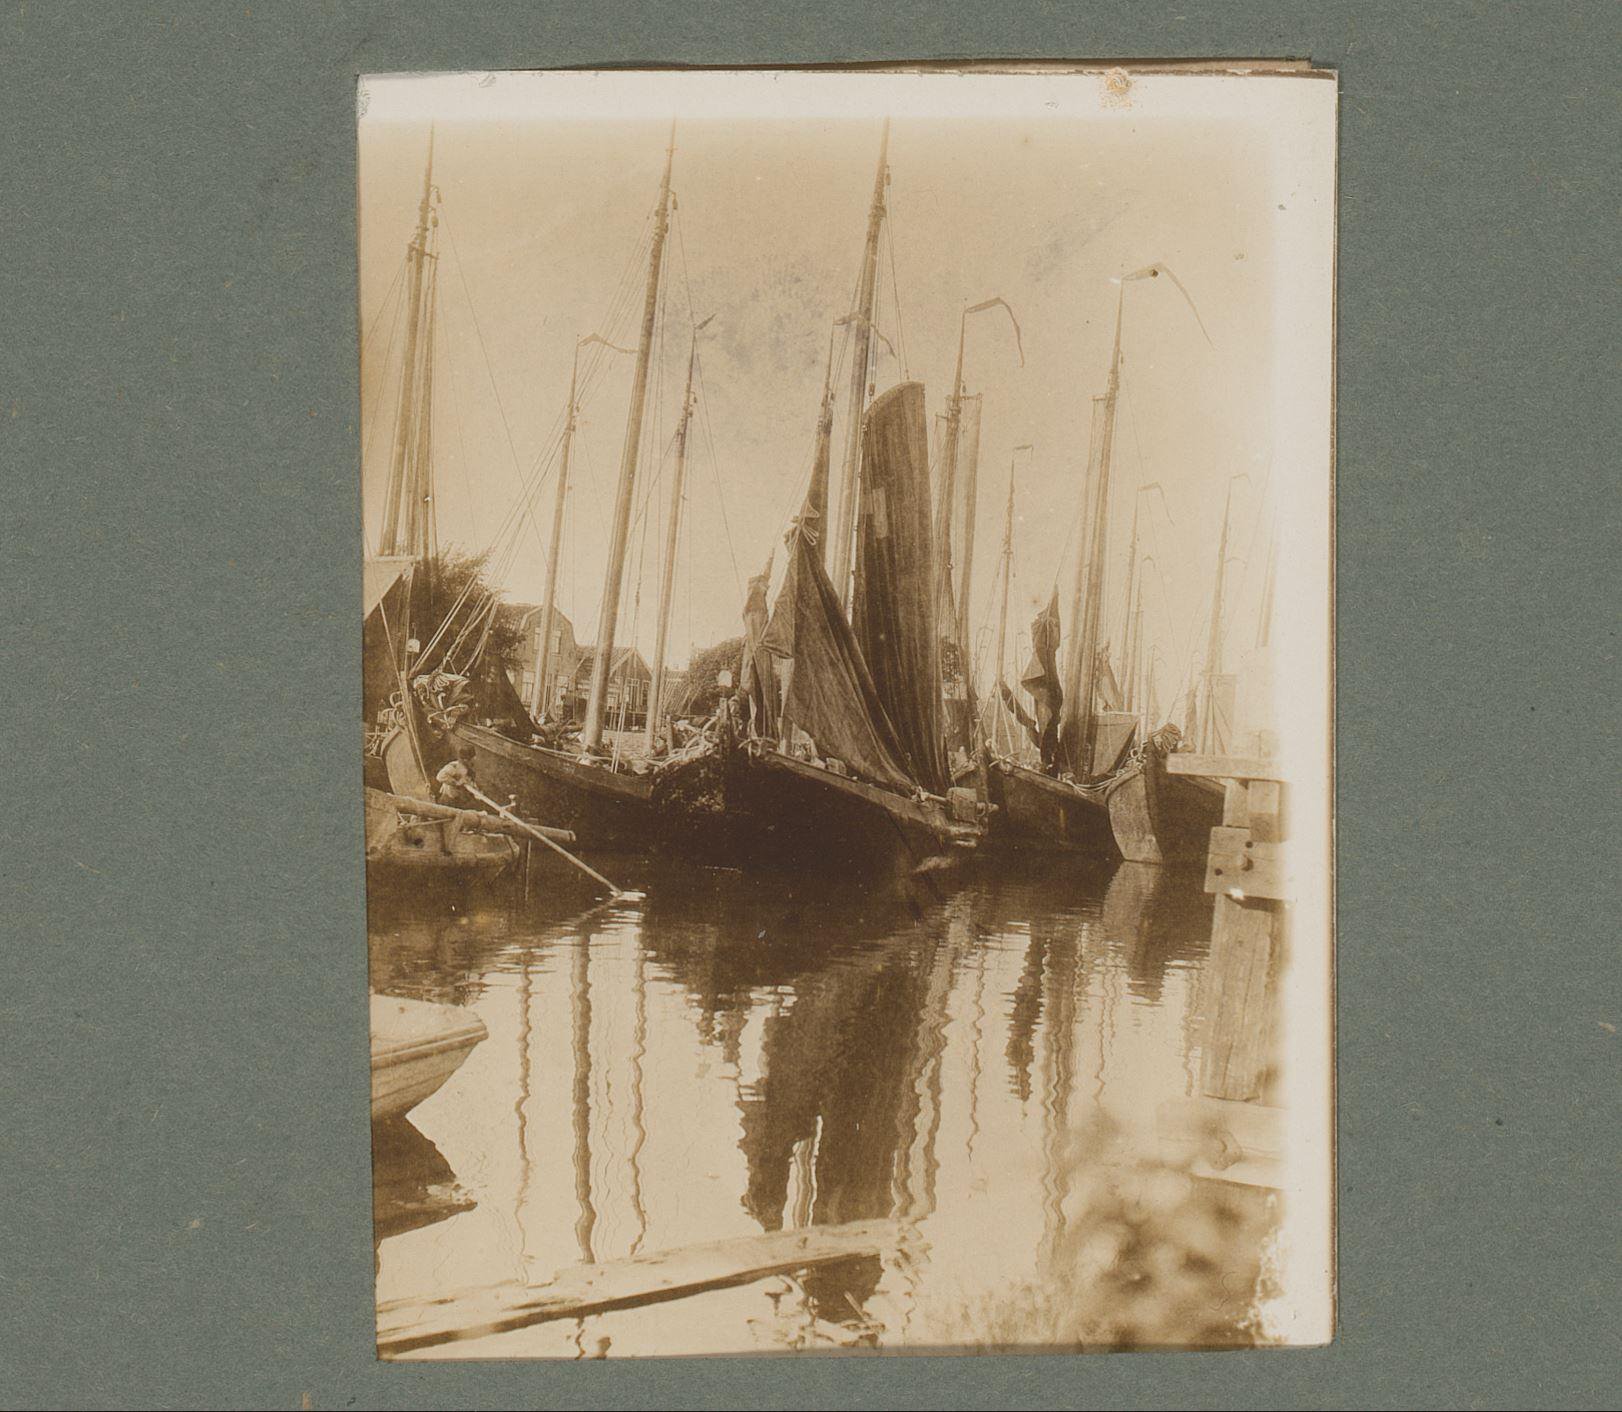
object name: photograph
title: Aangemeerde zeilboten in een haven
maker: george hidderley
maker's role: fotograaf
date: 1920-1940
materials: photographic support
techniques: gelatin silver print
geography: netherlands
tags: sailing-ship, sailing-boat, pier, quay, wharf